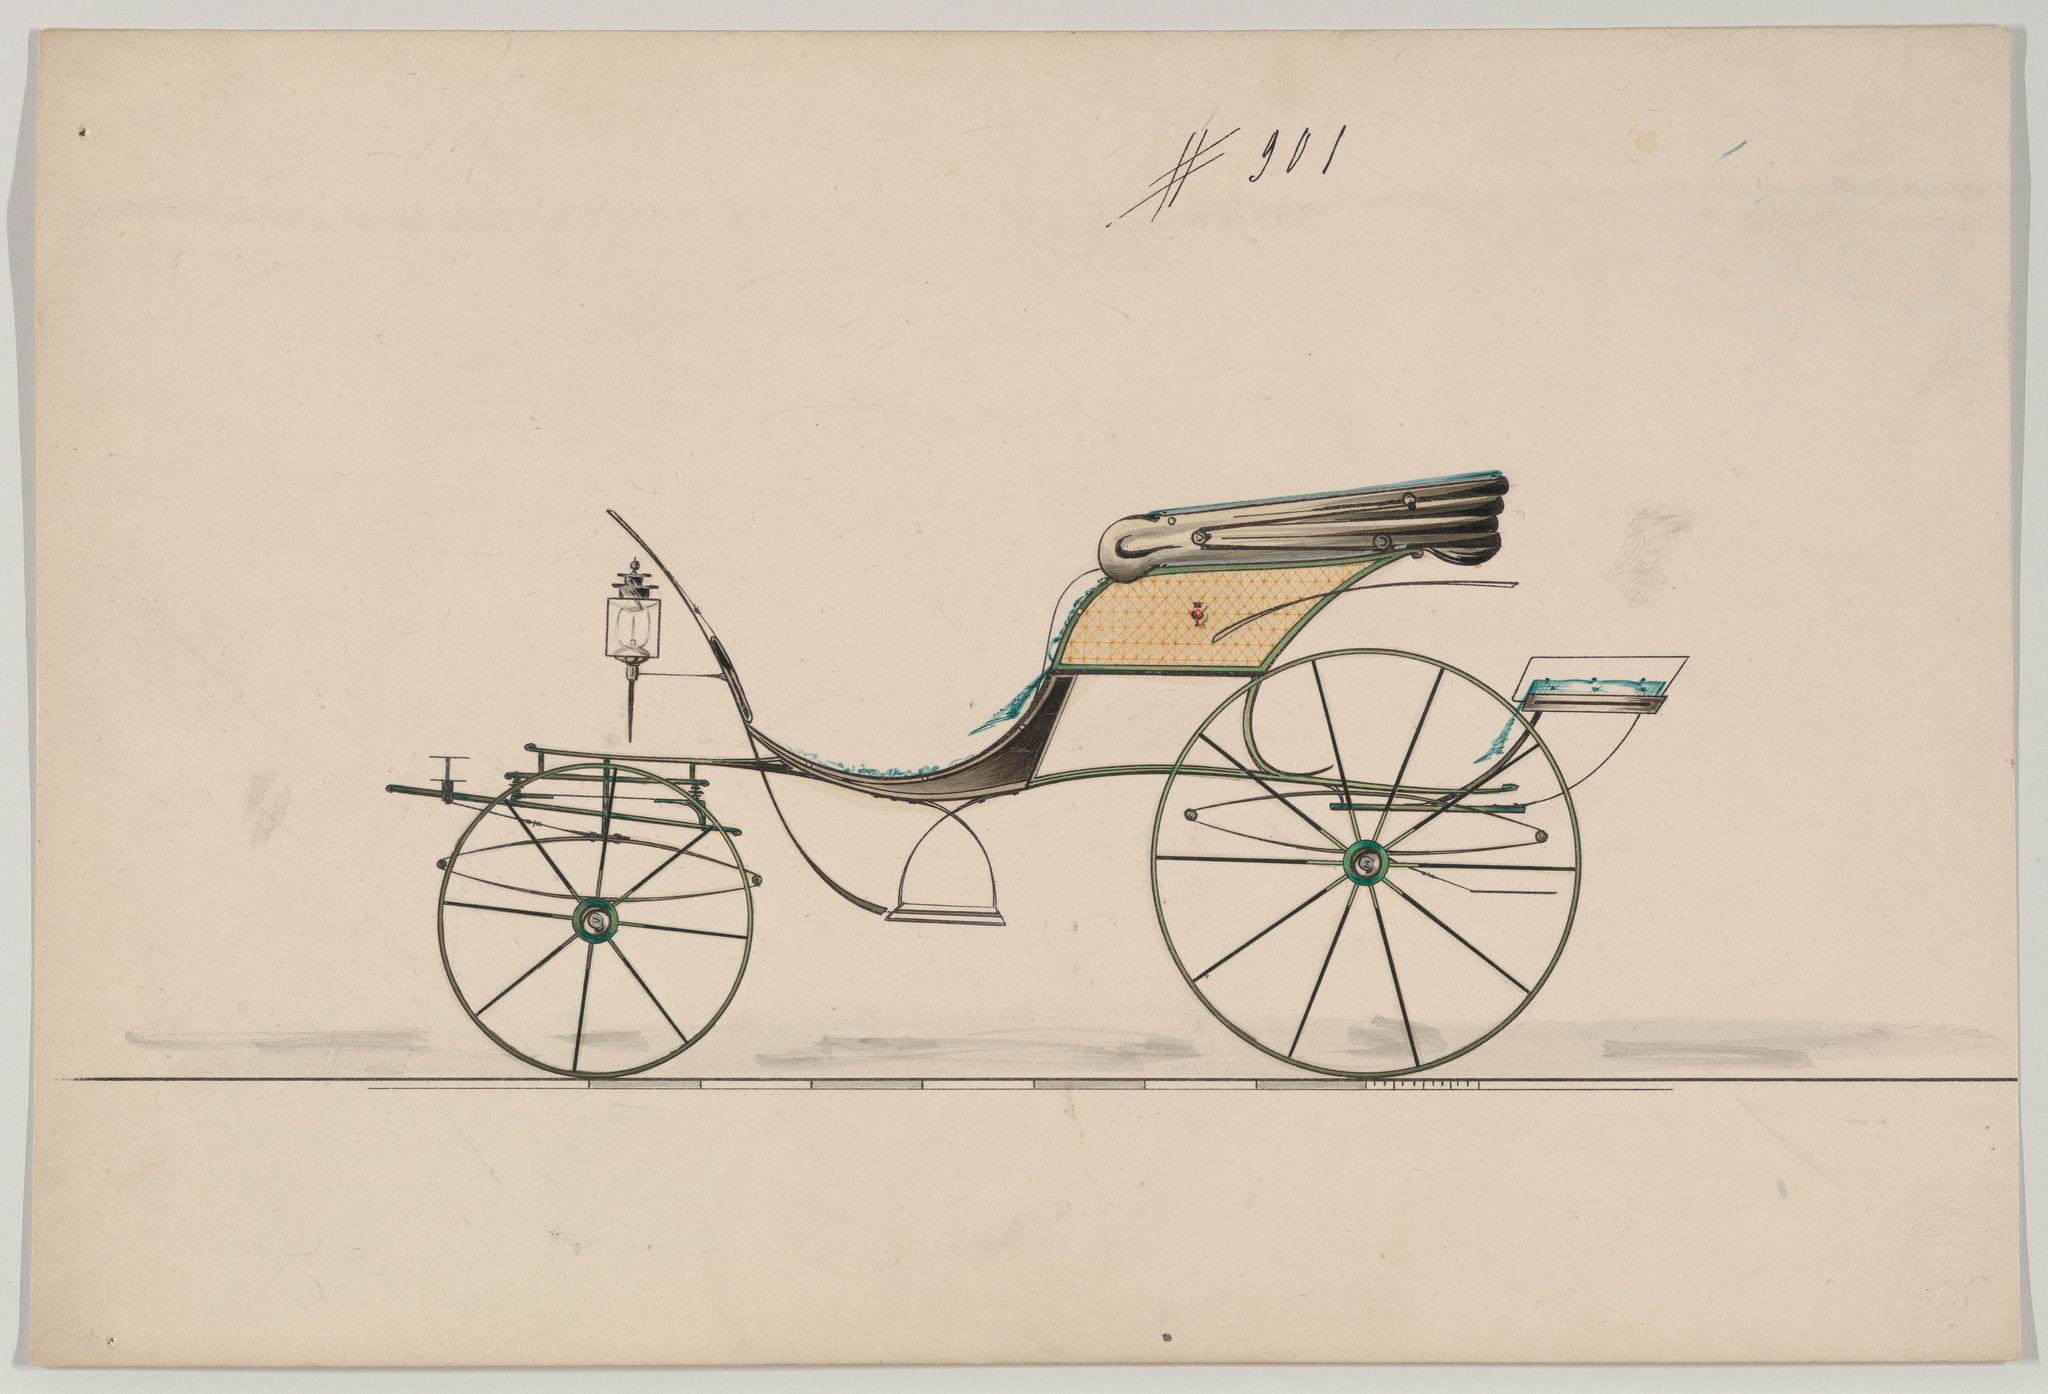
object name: drawing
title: Phaeton #901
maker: brewster & co.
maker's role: manufacturer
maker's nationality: american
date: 1870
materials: gouache, graphite, gum arabic, ink, watercolor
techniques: pen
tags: carriages